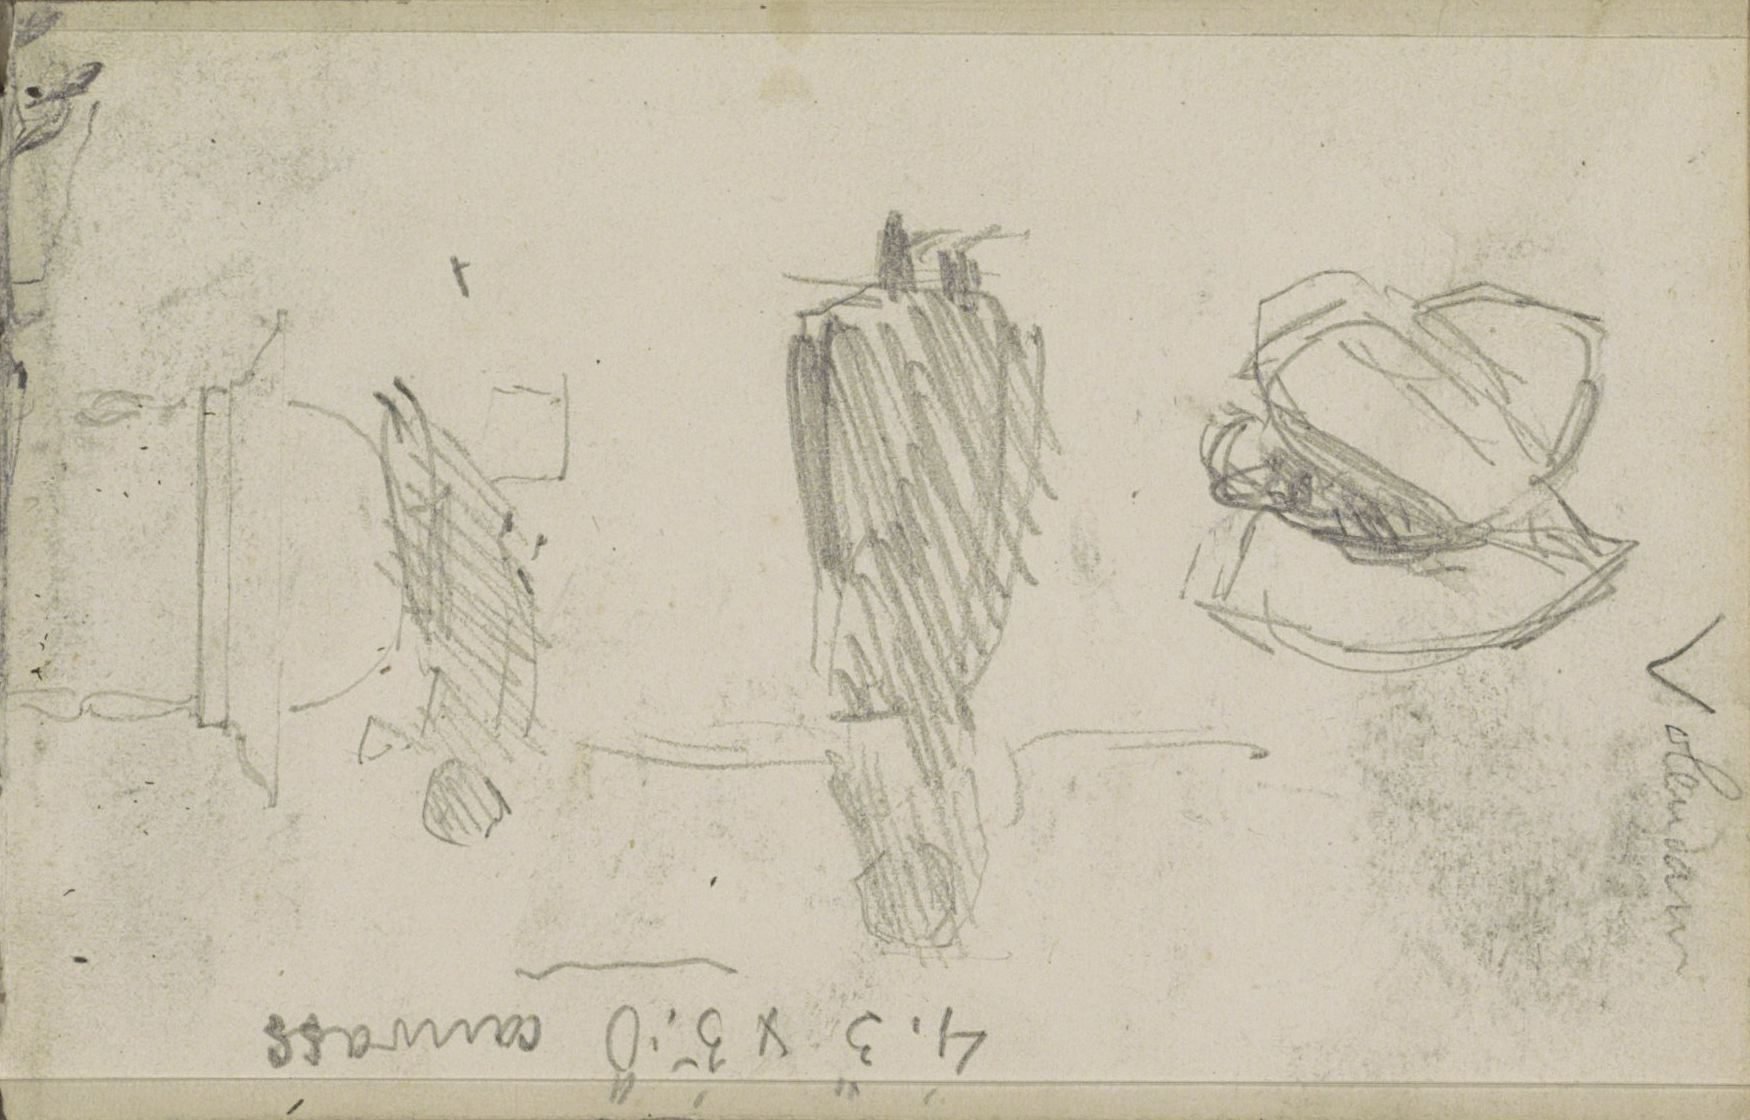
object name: sketchbook leaf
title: Figuren in Volendamse klederdracht en een muts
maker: george clausen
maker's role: draughtsman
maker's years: 1852-1912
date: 1875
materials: paper, pencil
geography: volendam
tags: folk costume, regional costume (+ women's clothes)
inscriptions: annotation: ‘Volendam/ 4.3 x 3.8 canvass’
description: Blad 37 recto uit een schetsboek met 38 bladen.